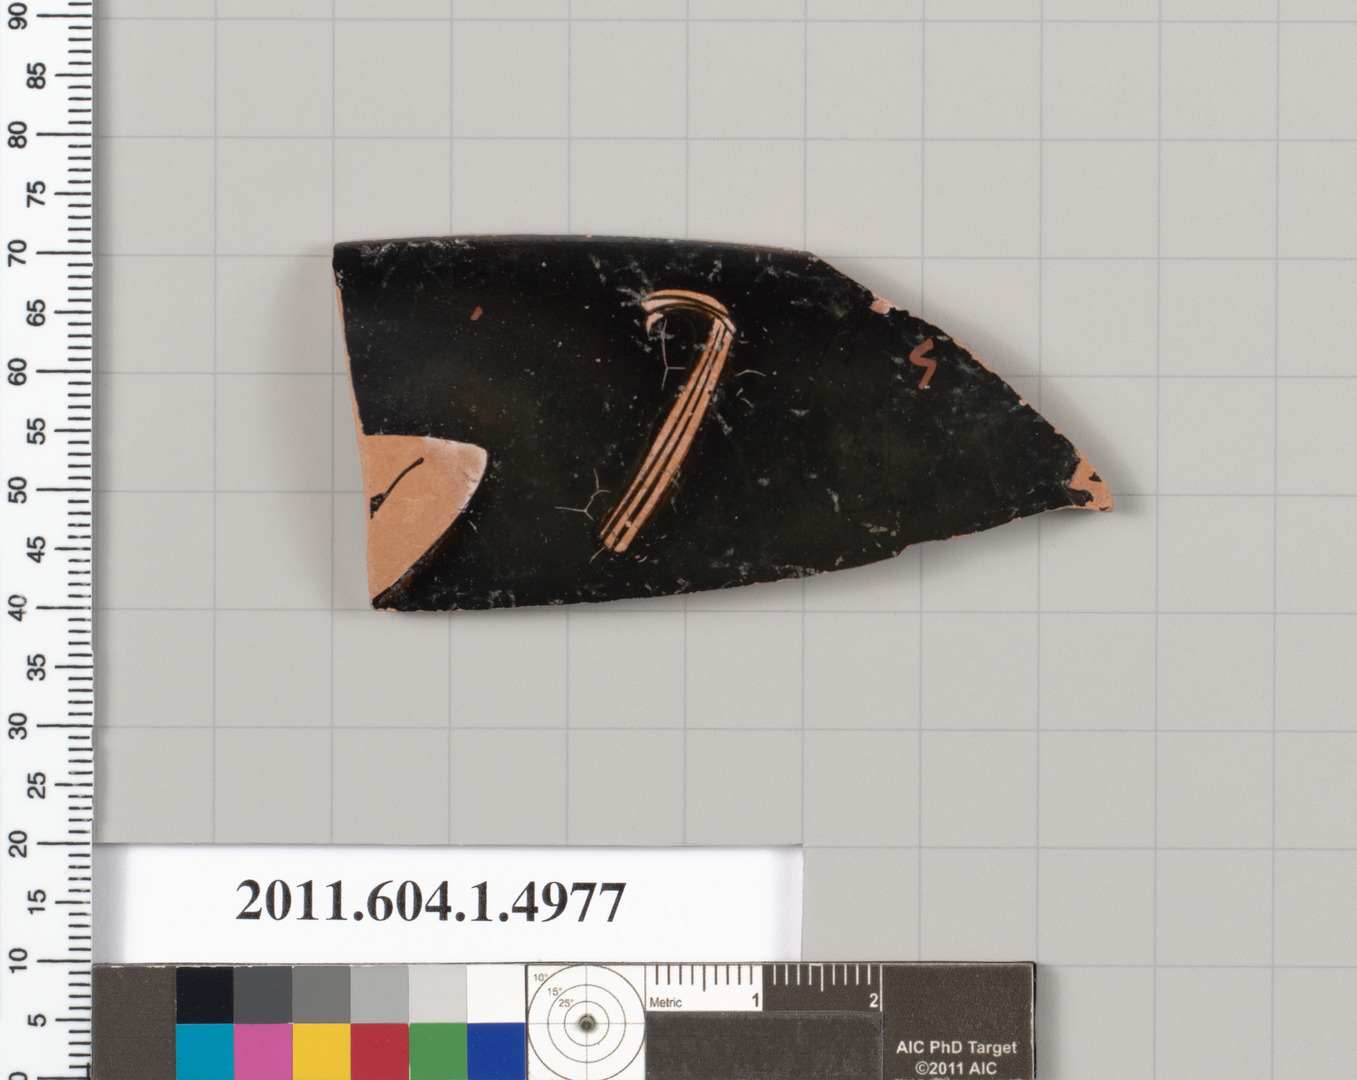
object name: kylix fragment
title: Terracotta rim fragment of a kylix (drinking cup)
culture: greek, attic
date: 500-480 BCE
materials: terracotta